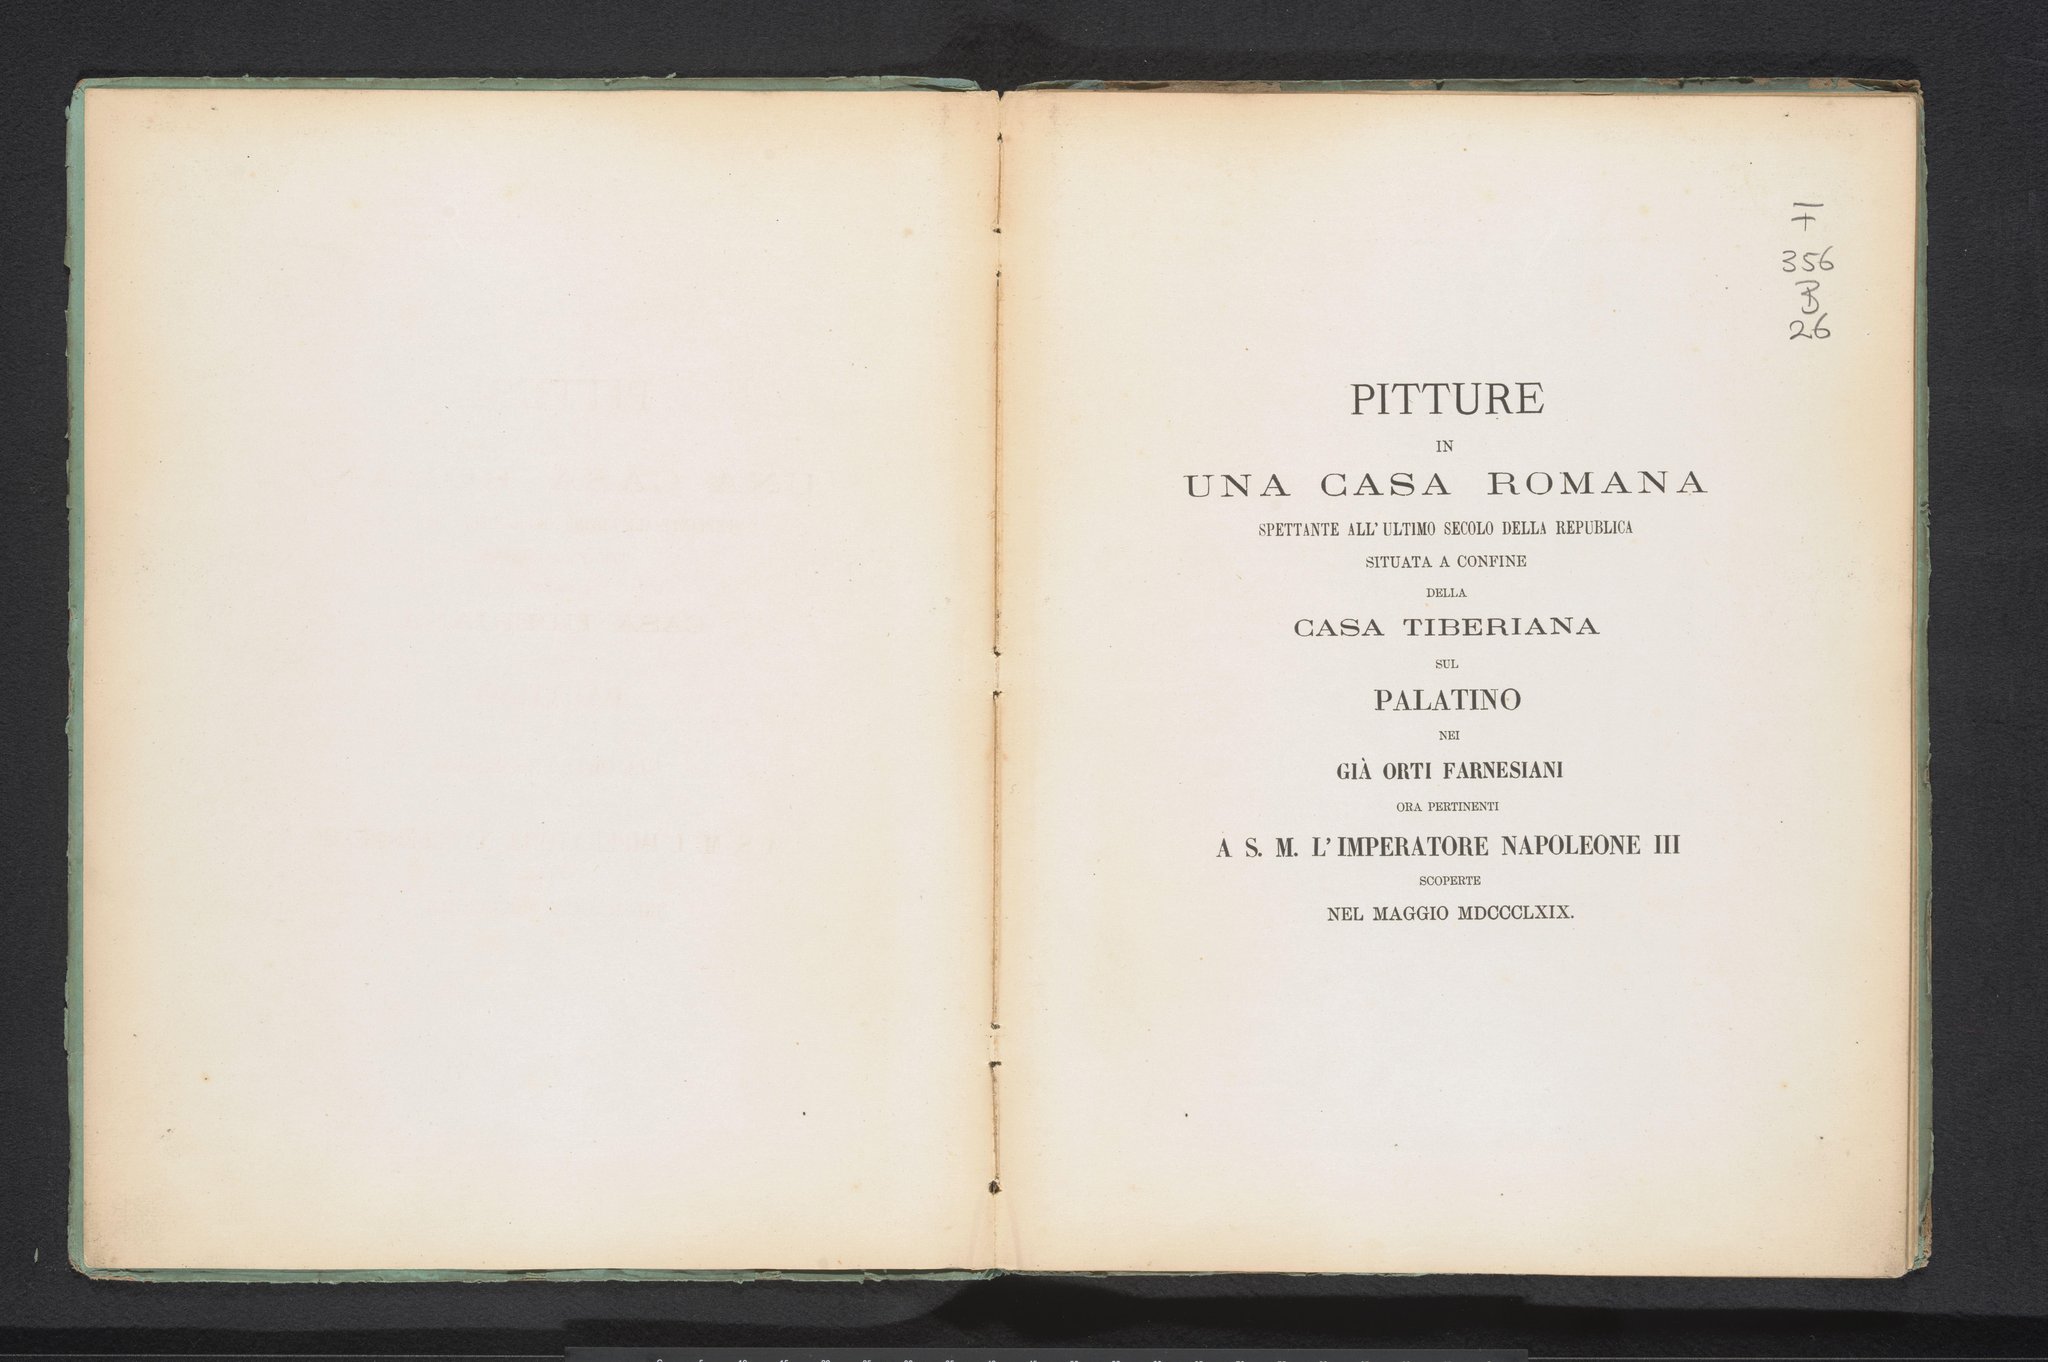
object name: book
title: Pitture in una casa romana spettante all'ultimo secolo della Republica situata a confine della Casa Tiberiana sul Palatino nei già orti farnesiani ora pertinenti a S.M. l'imperatore Napoleone III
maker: Anonymous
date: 1869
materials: cardboard, paper, photographic support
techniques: albumen print